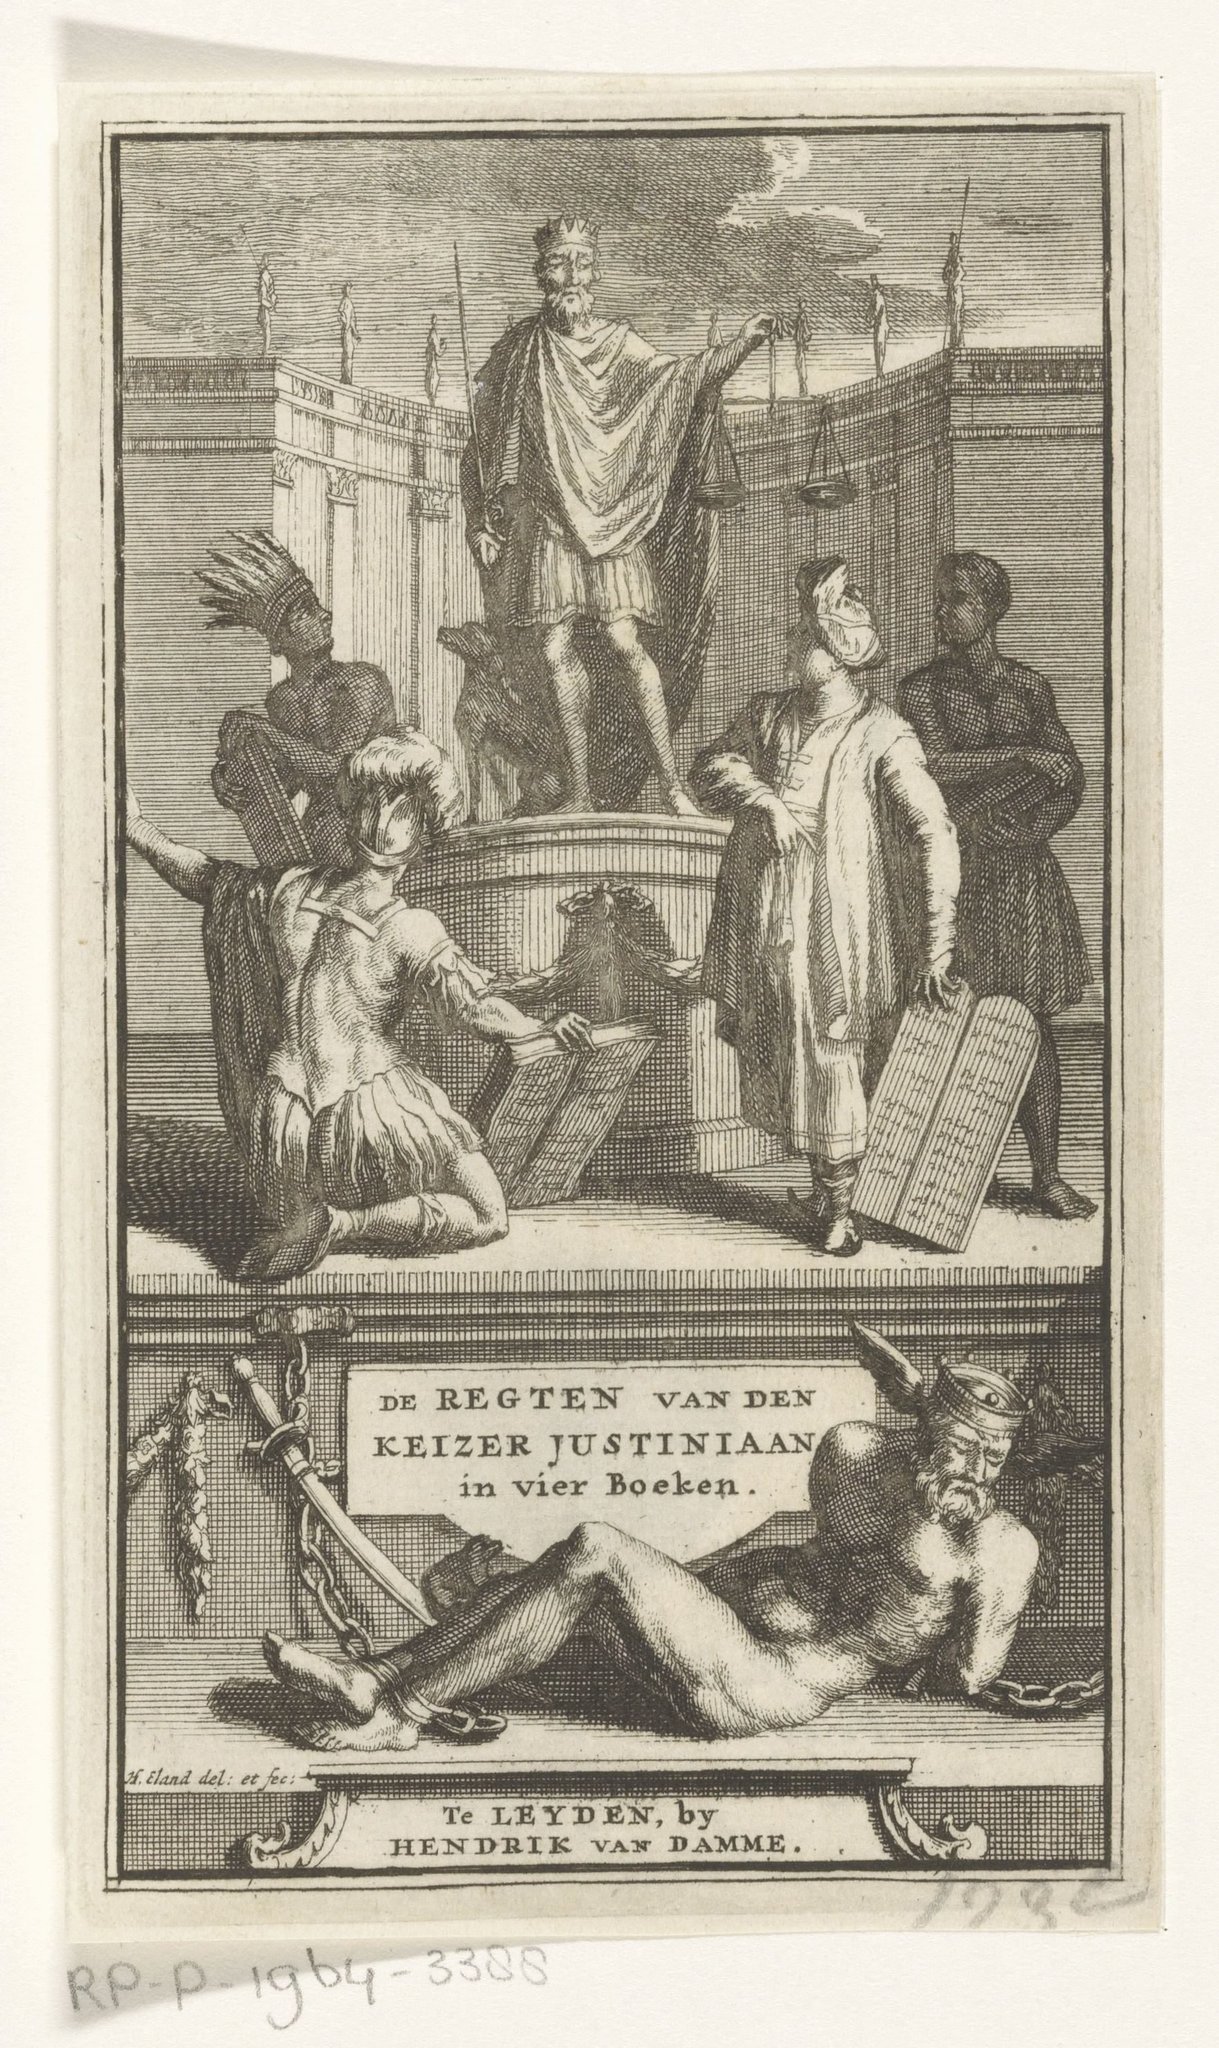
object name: print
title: Justinianus omringd door vier werelddelen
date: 1728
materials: paper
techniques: etching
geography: utrecht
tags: macedonië, justinianus i (keizer van het byzantijnse rijk)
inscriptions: collector's mark: Lugt 2760, collector's mark: Lugt 2228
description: Keizer Justinianus staand op een voetstuk, met weegschaal en lans in handen en hond aan de voeten. Hij wordt omringd door personificaties van de werelddelen Europa, Afrika, Azië en Amerika. Onderaan ligt een naakte geketende man met een gevleugelde kroon op en een dier op z'n been.